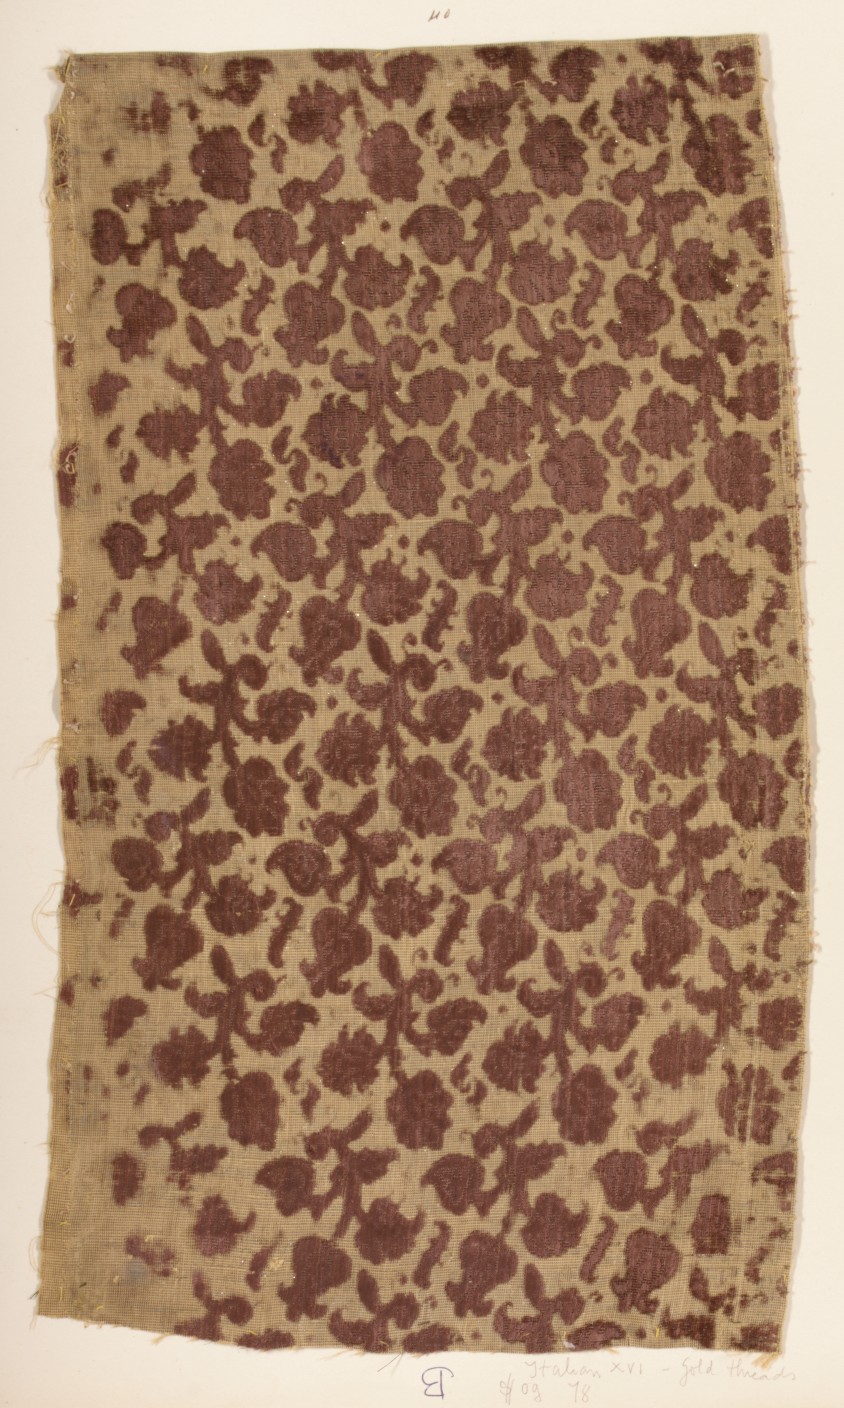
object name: fragment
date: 1501-1600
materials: metal thread, silk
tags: leaves